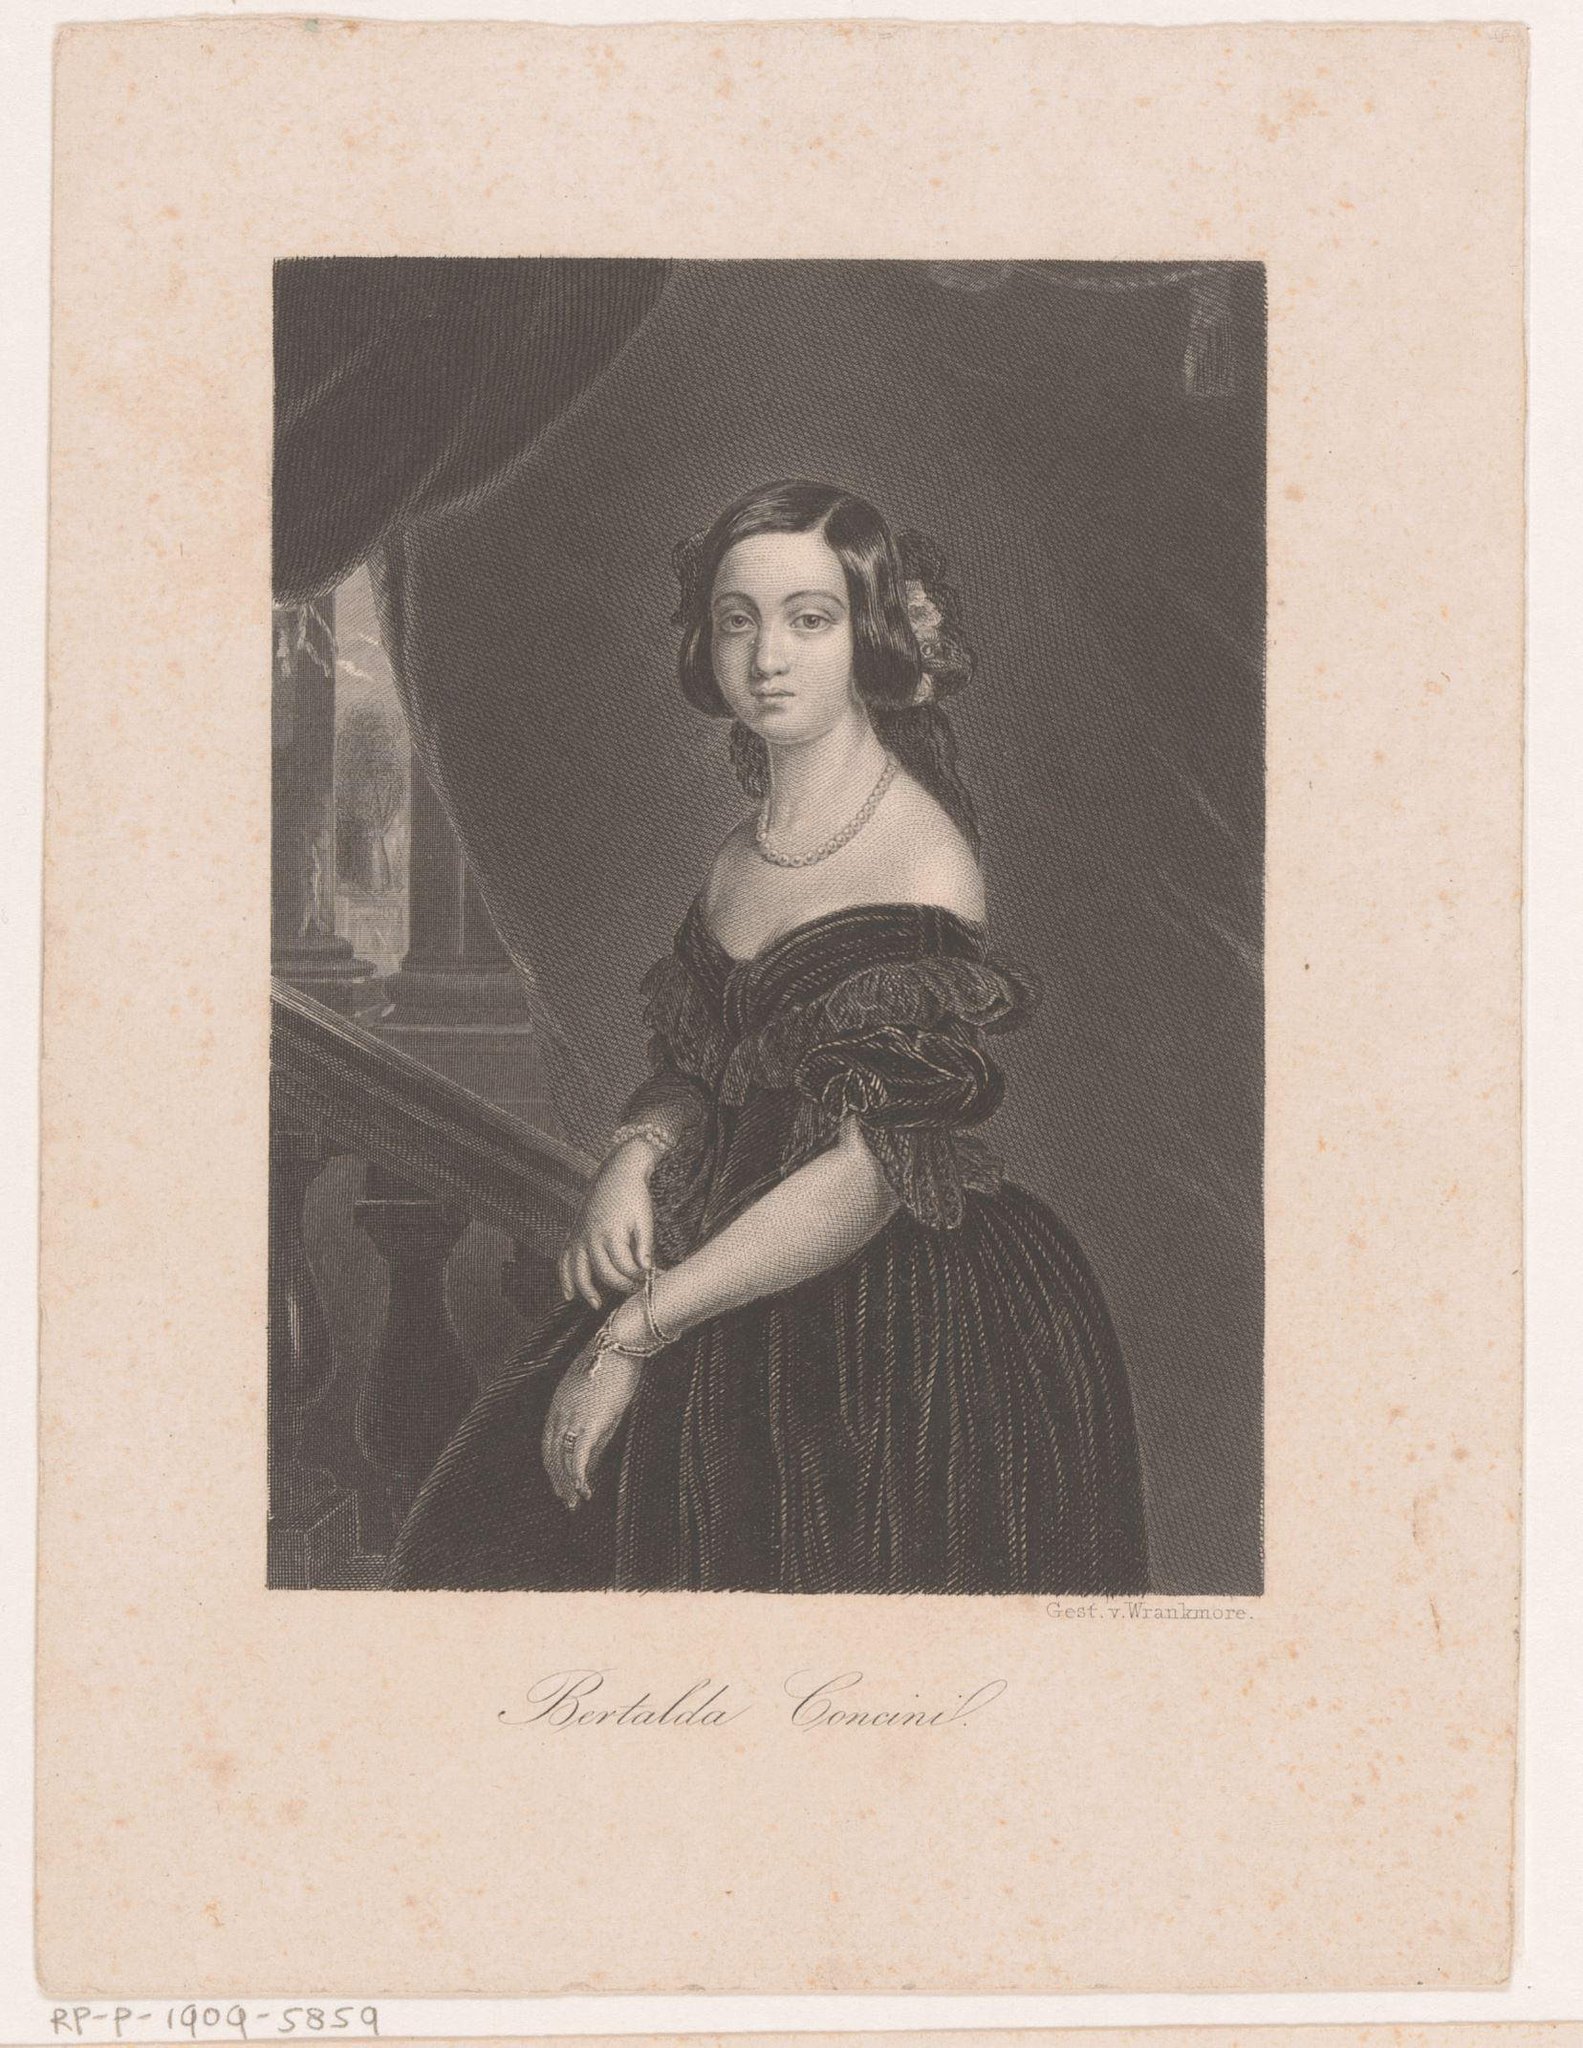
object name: print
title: Portret van Bertalda Concini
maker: william colley wrankmore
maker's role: print maker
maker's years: 1812-1891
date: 1826-1840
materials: paper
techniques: engraving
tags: historical persons, staircase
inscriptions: collector's mark: Lugt 2228